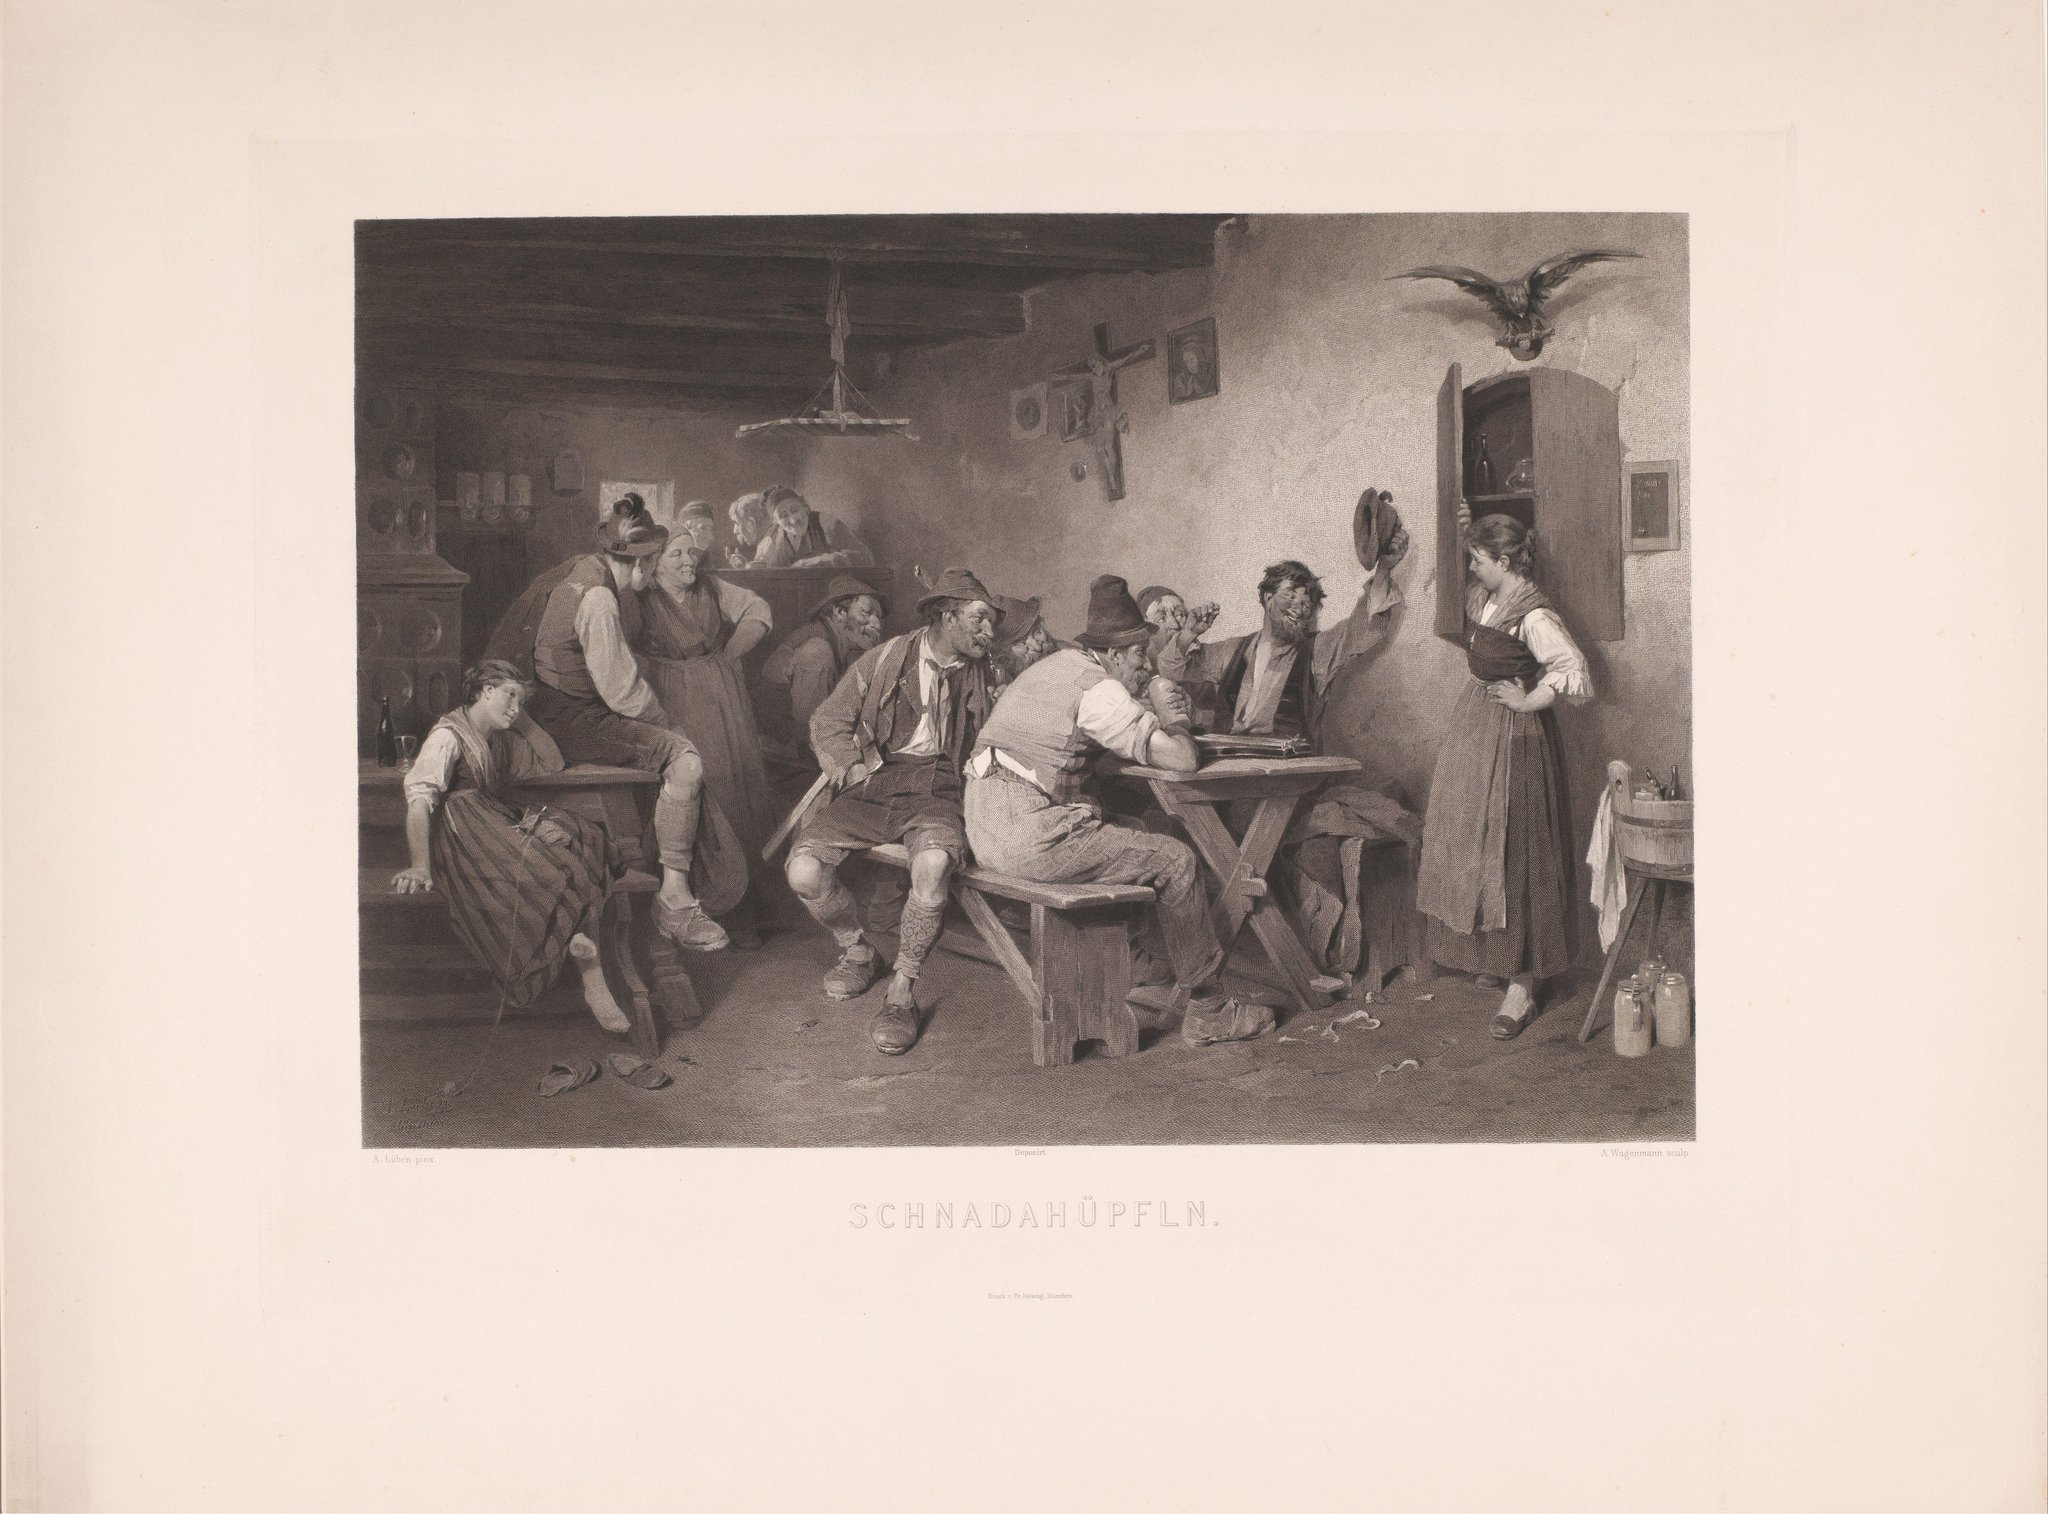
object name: print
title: Gezelschap in een herberg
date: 1849-1905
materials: paper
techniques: etching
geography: munich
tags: hotel, hostelry, inn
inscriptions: collector's mark: Lugt 2228, : ‘Deponirt.’